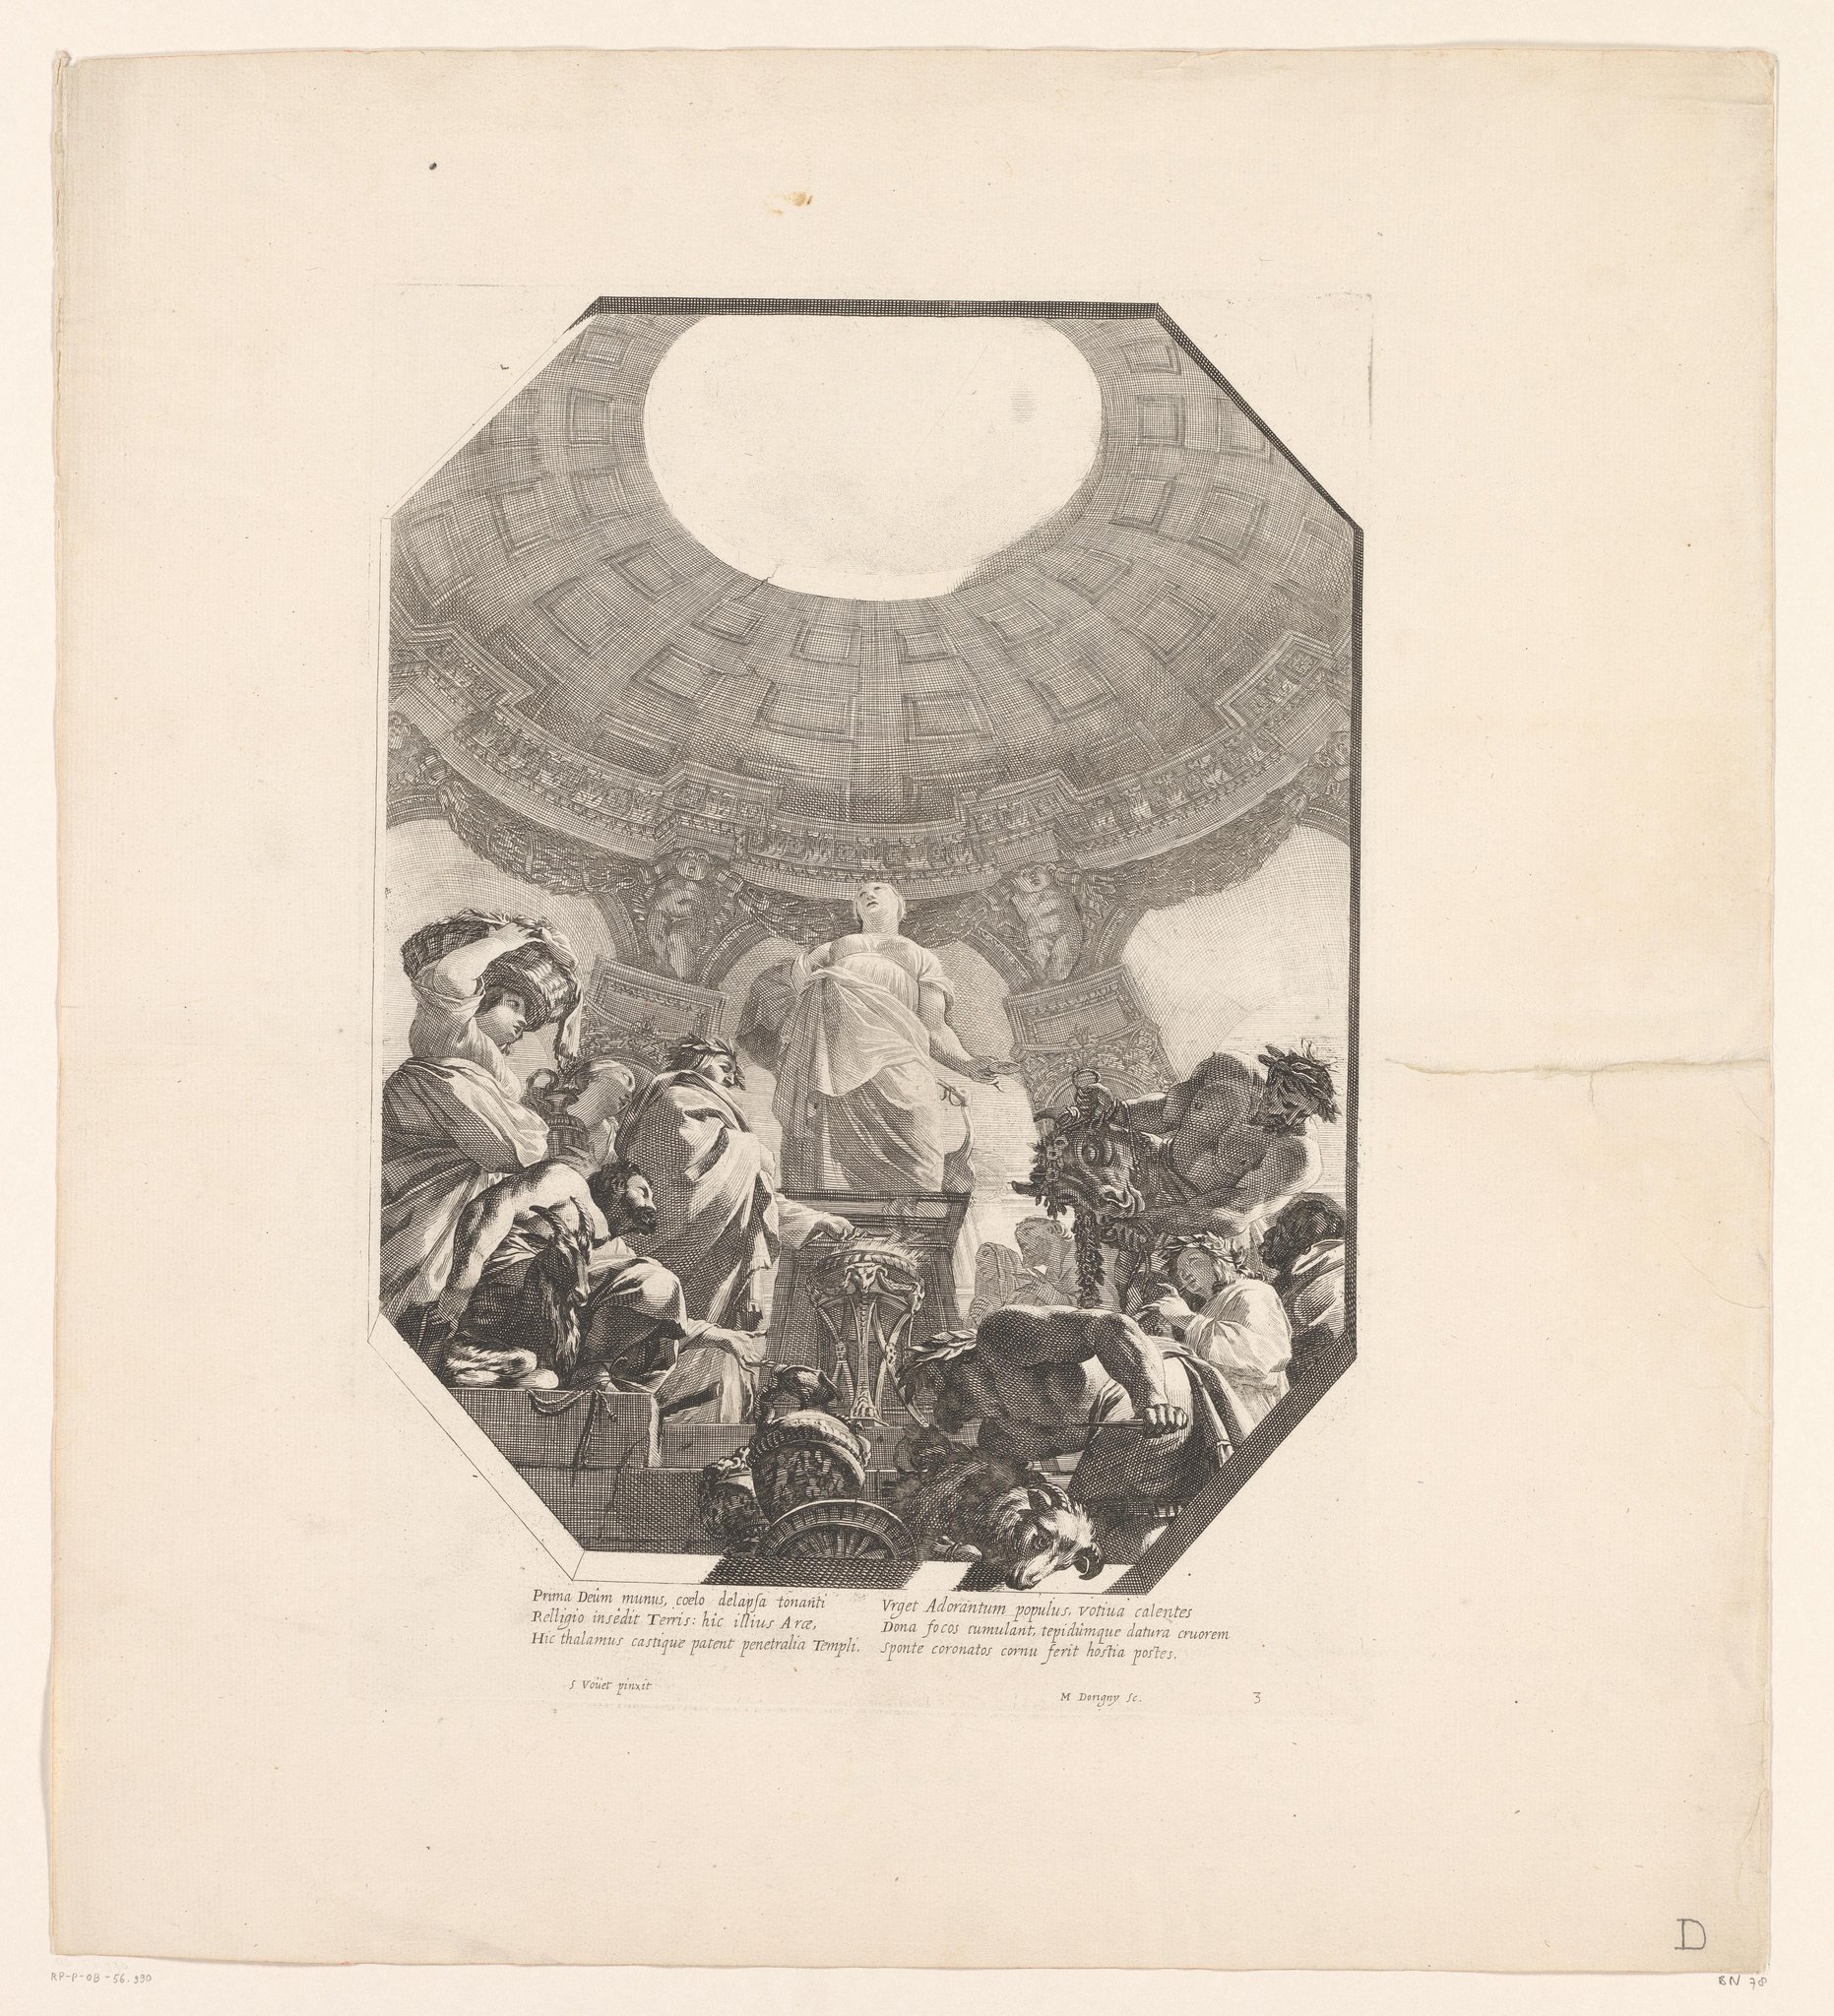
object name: print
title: Decoratie van de gewelven van de bibliotheek in Hôtel Séguier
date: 1640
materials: paper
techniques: engraving, etching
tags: human sacrifice ~ roman religion, justitia (justice) as roman personification, (decorated) ceiling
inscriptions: collector's mark: Lugt 2228